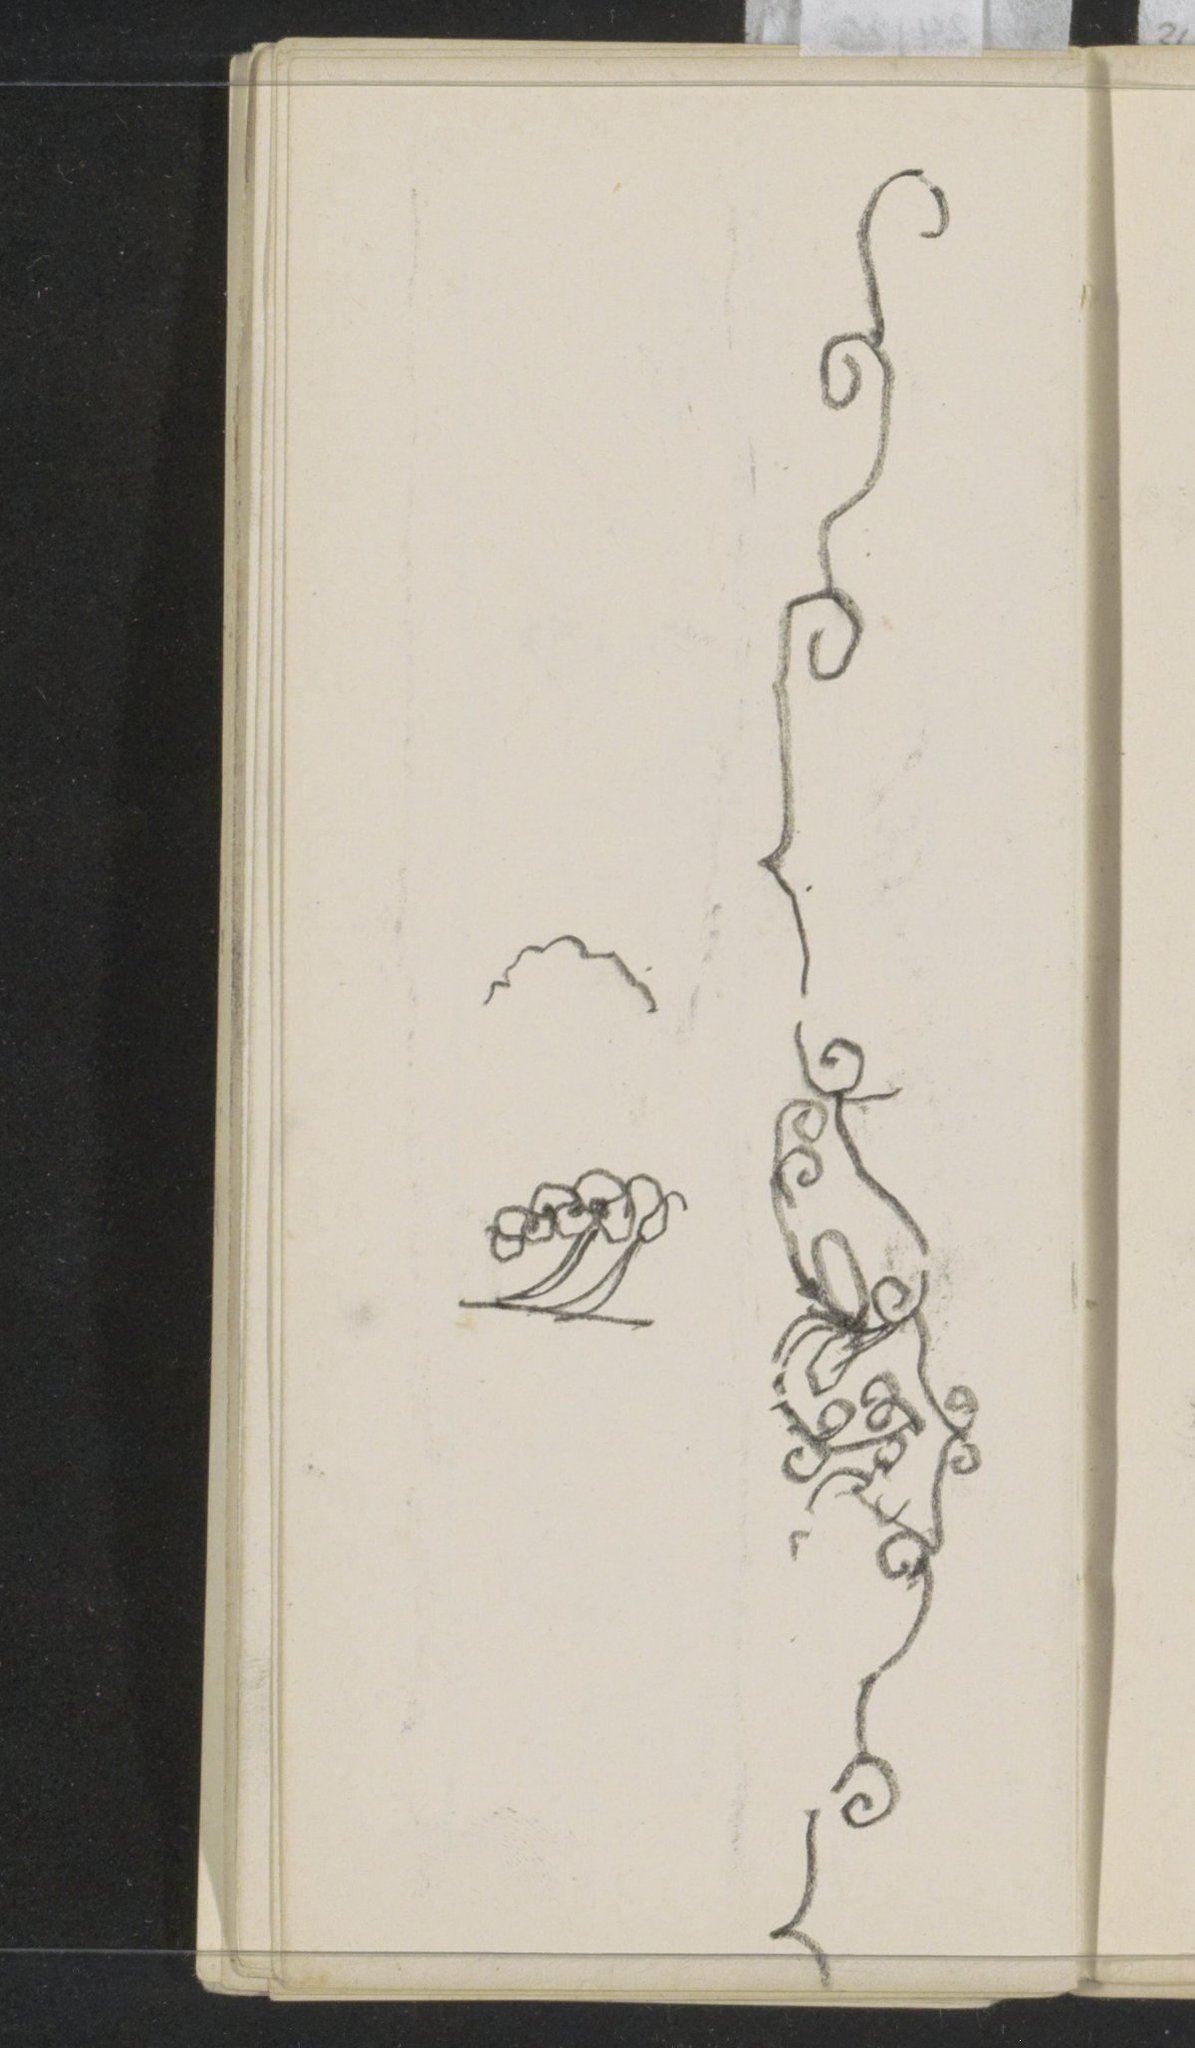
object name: sketchbook leaf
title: Slinger met plantmotief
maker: gerrit willem dijsselhof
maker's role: designer, draughtsman, print maker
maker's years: 1866-1924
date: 1901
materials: chalk, paper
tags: foliage, tendrils, branches ~ ornament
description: Blad 25 verso uit een schetsboek met 42 bladzijden.